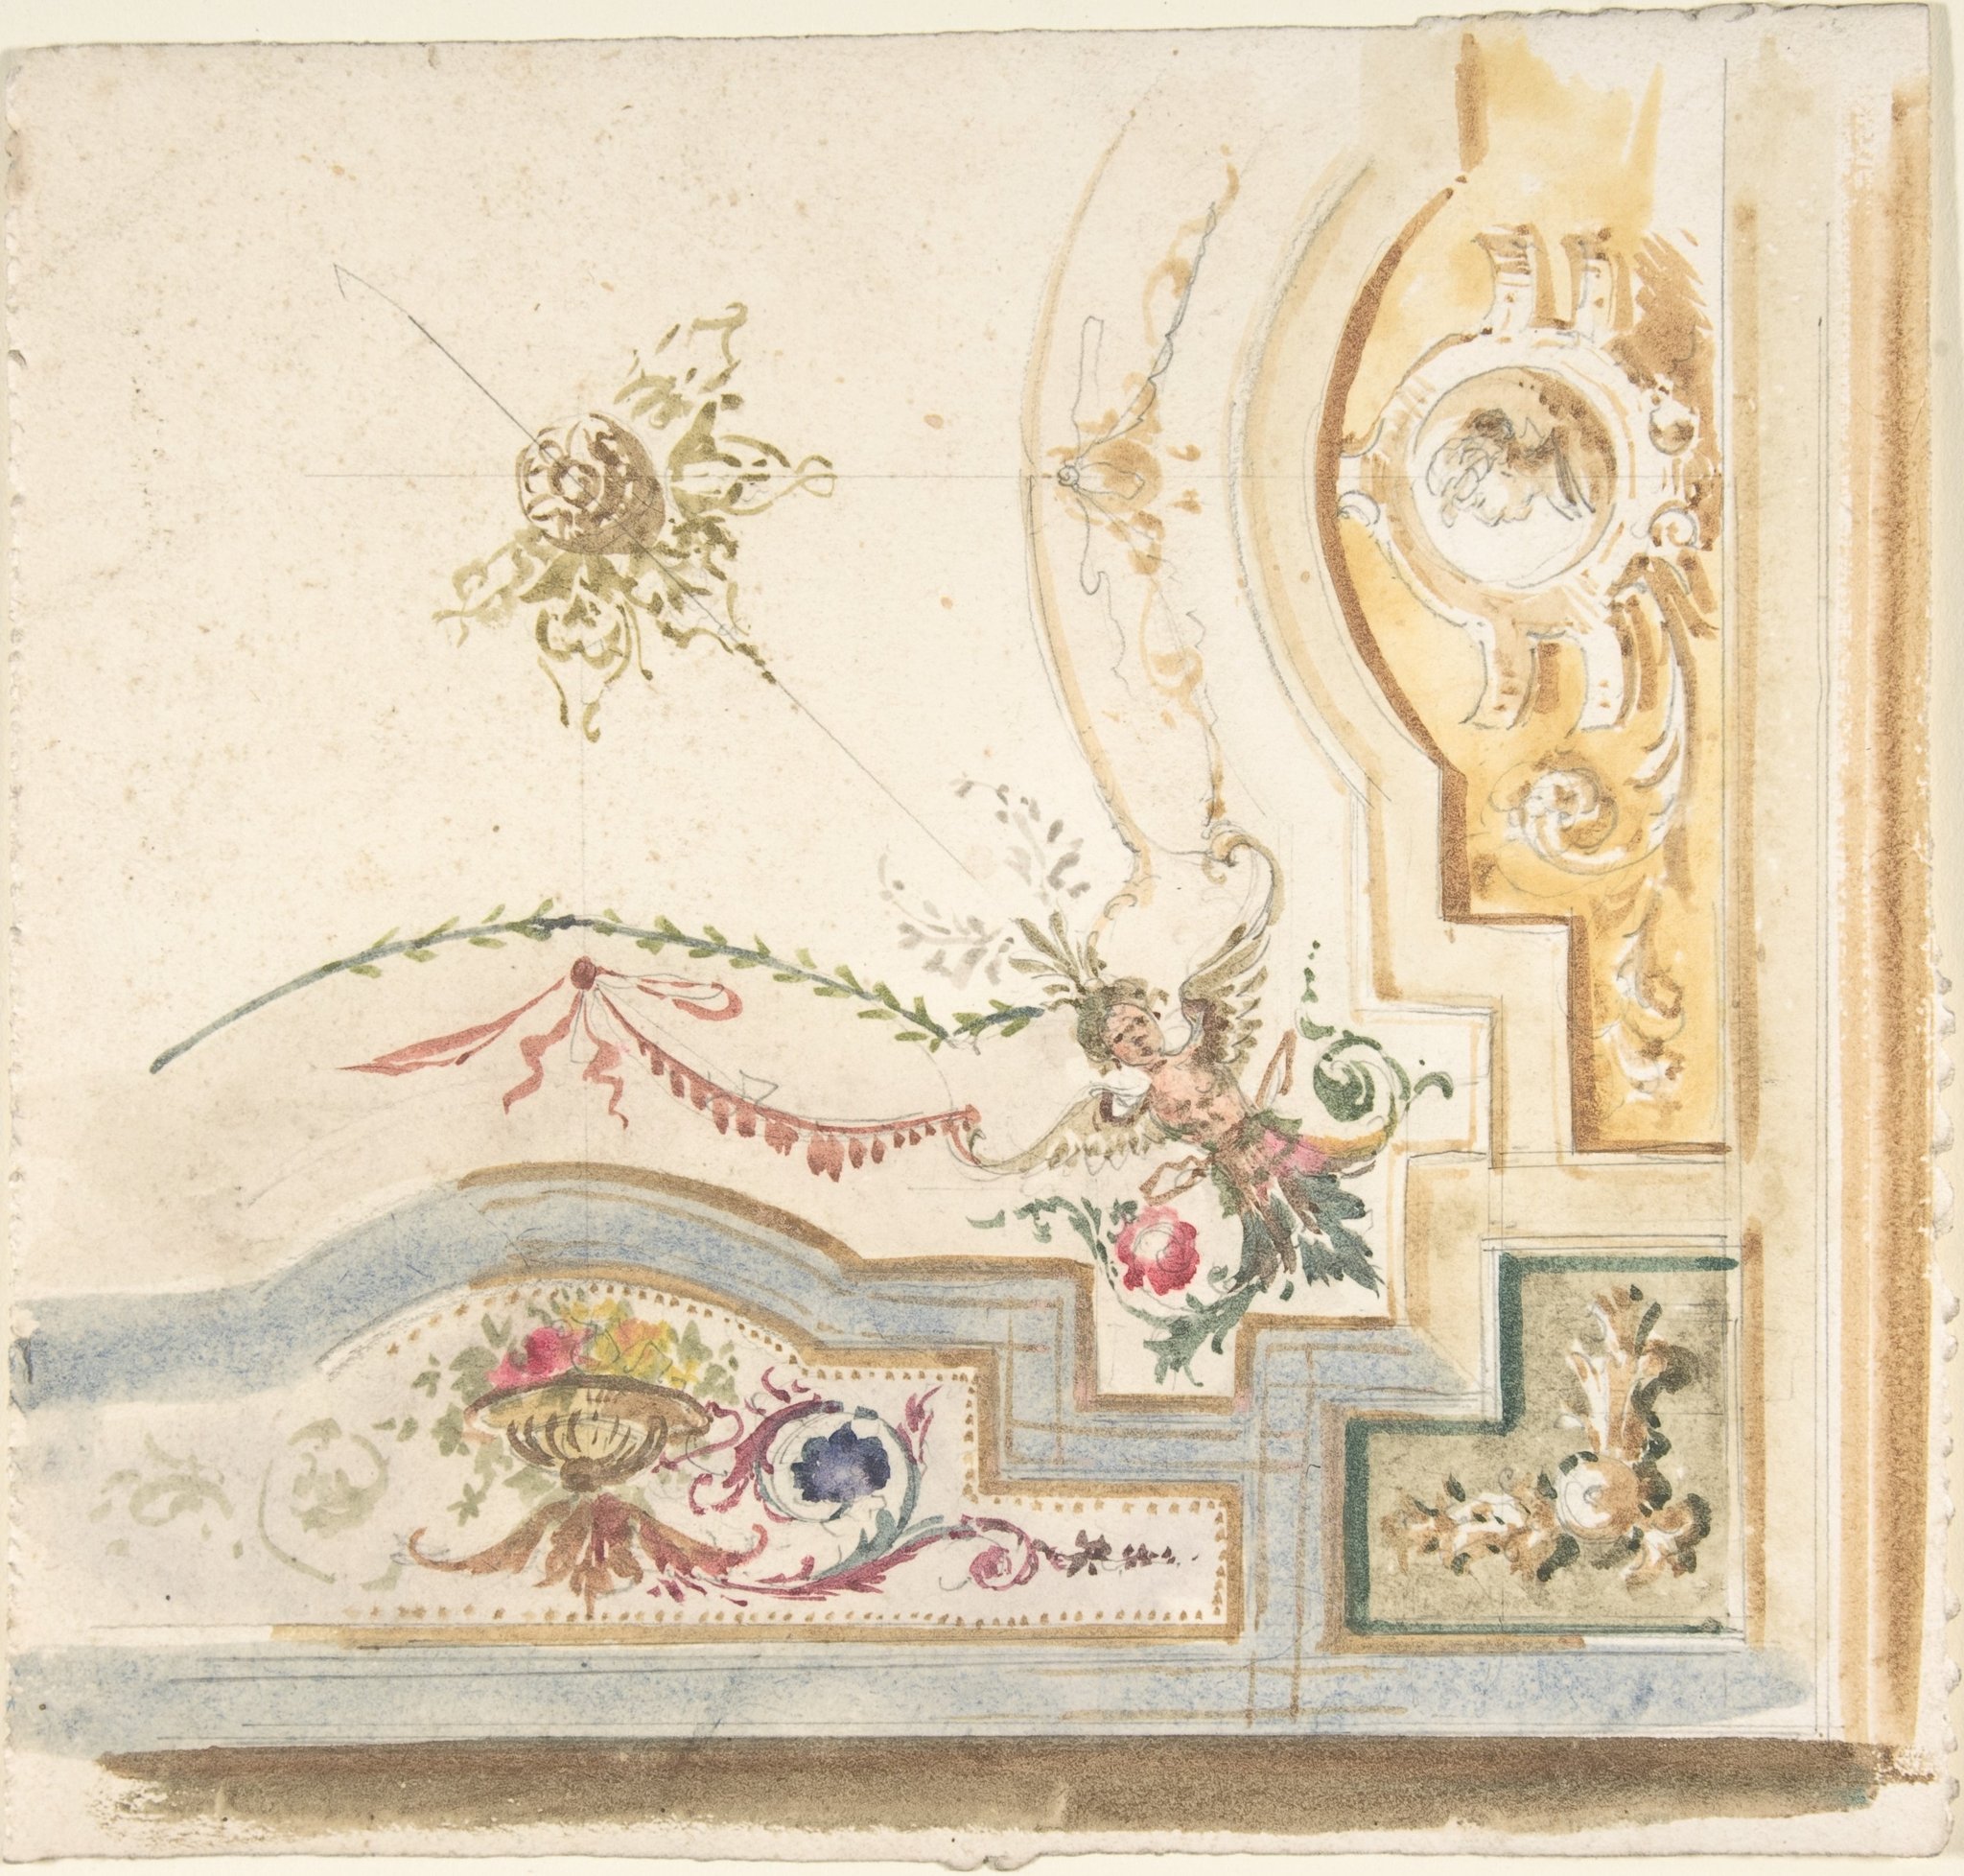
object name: drawing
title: Design for a Ceiling Decoration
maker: anonymous, italian, 19th century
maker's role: artist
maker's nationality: italian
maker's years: 1800-1900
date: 1800-1900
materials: watercolor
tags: ceilings